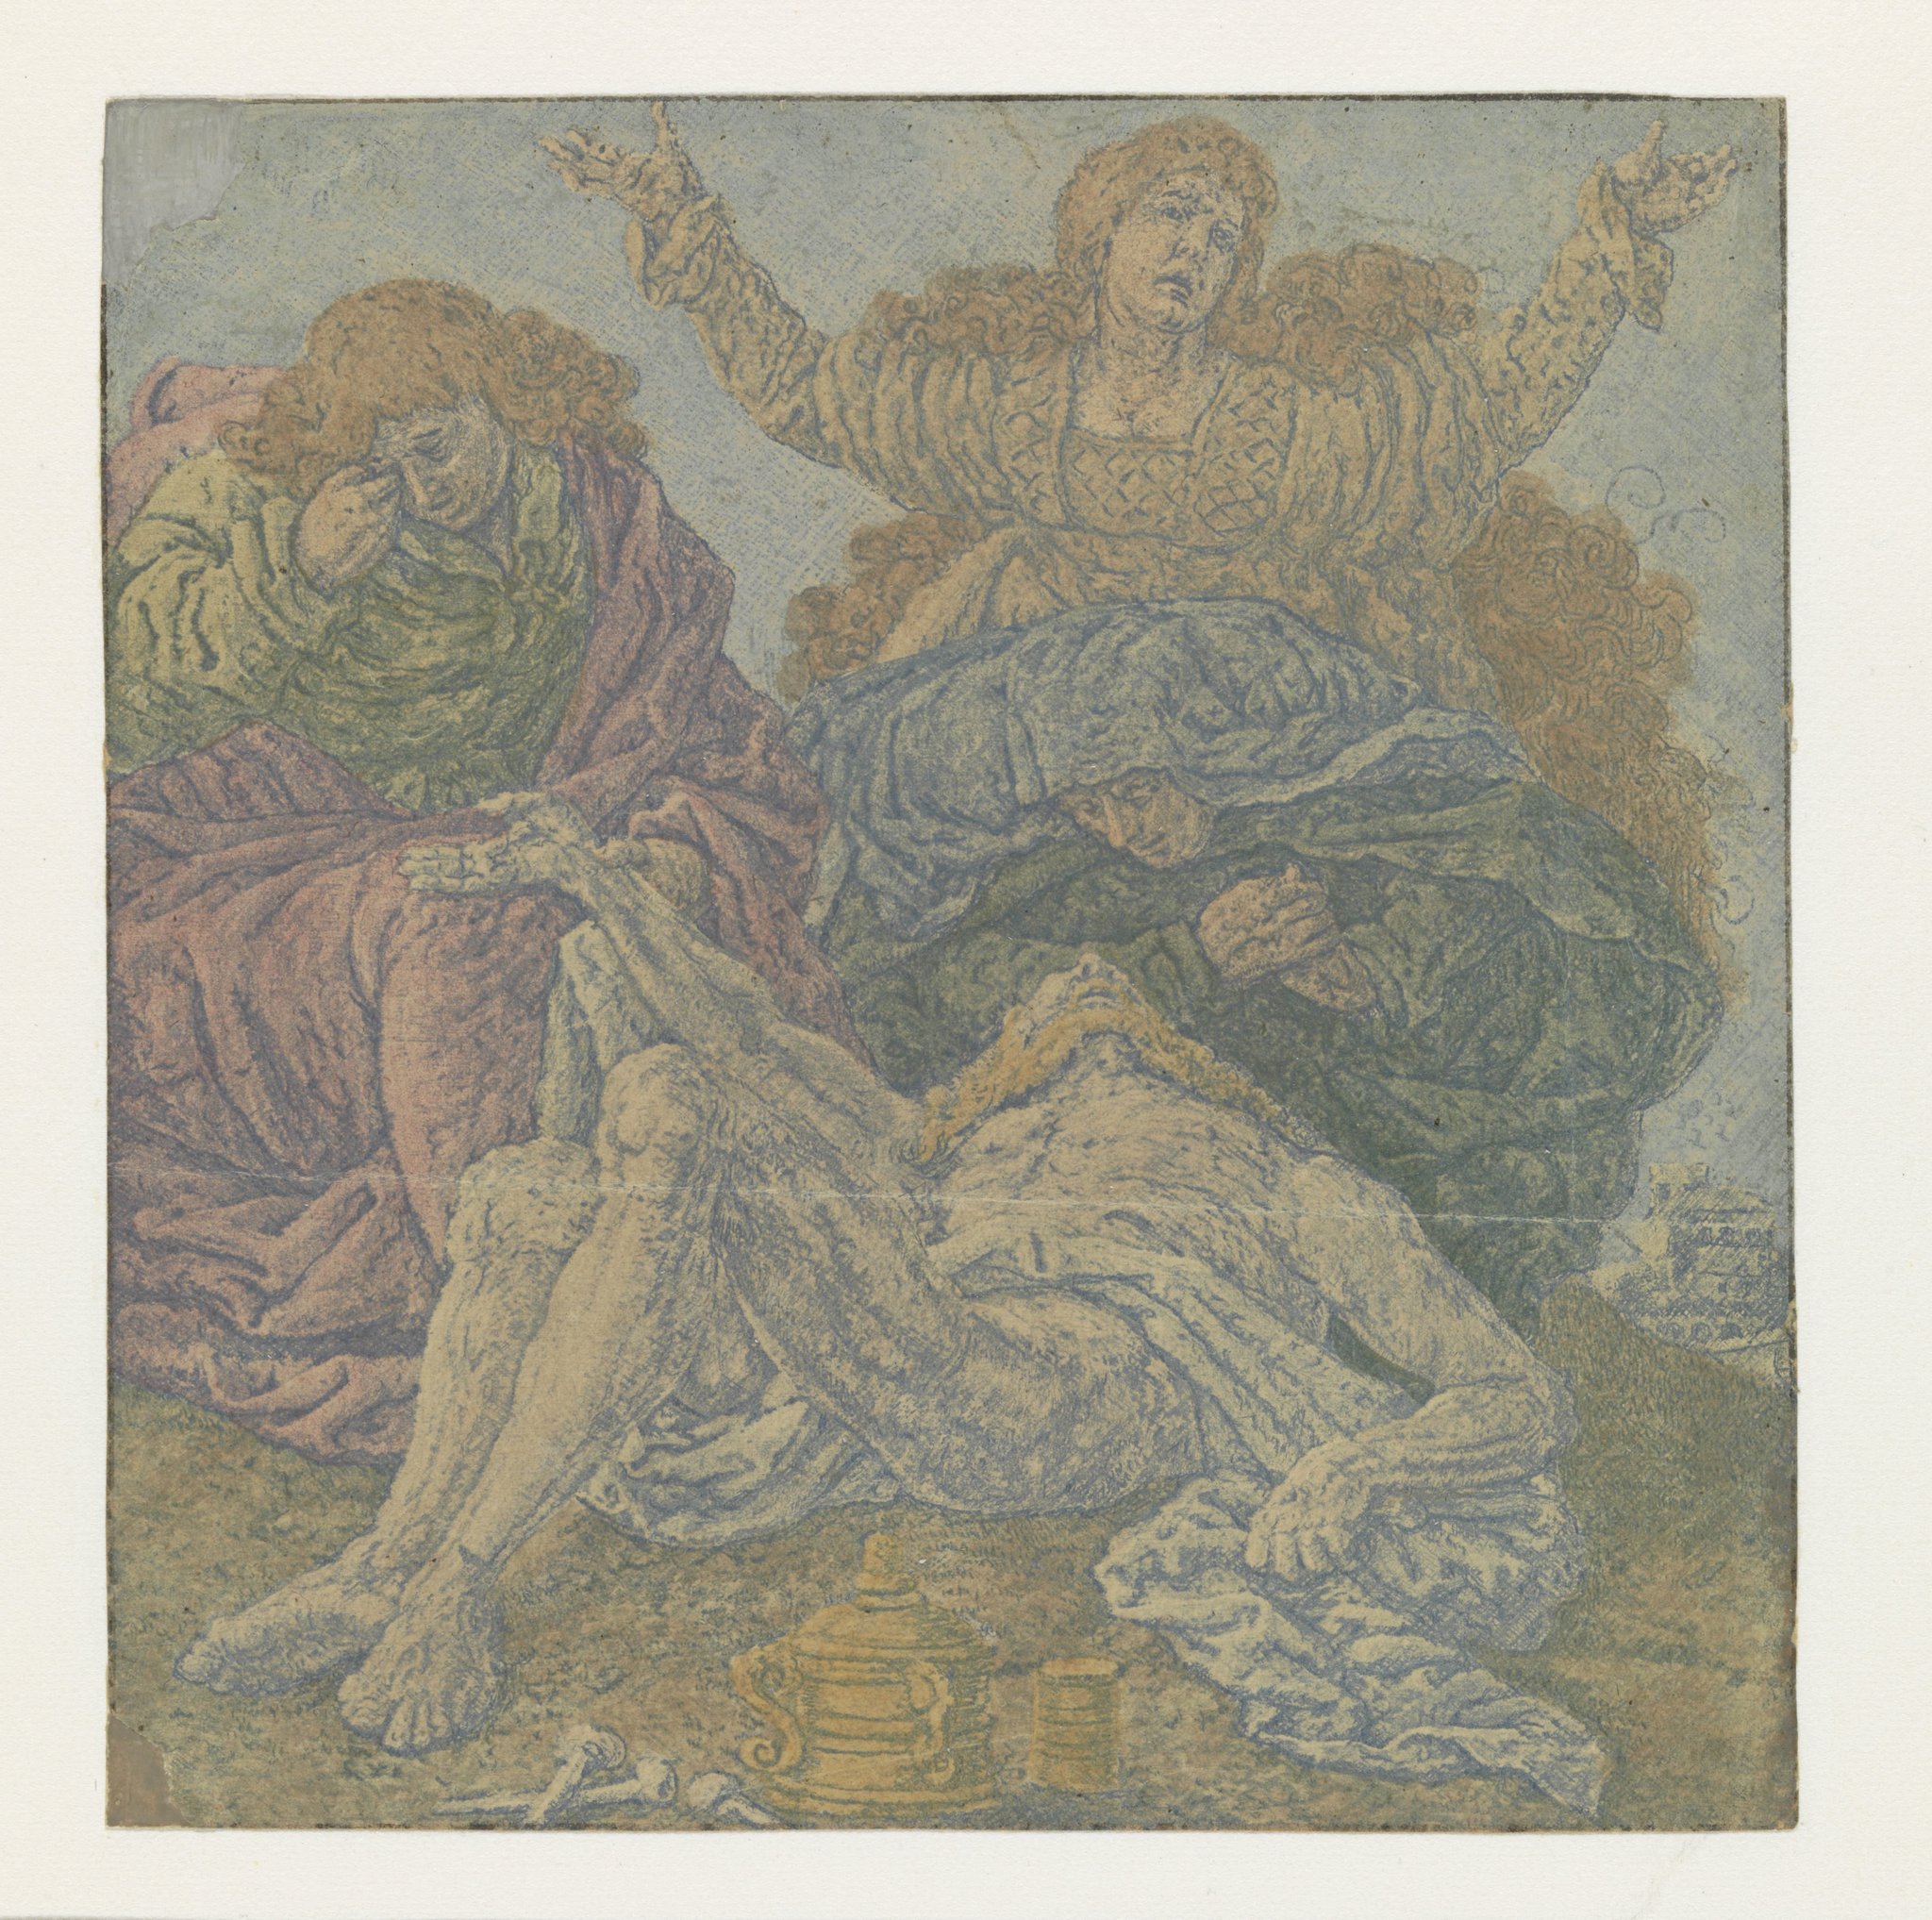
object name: print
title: The Lamentation of Christ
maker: hercules segers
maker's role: draughtsman, painter, print maker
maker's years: 1589-1640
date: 1630-1633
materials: paint, oil, paper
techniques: etching, hand coloring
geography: amsterdam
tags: christ's body lying on the ground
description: Segers overpainted an impression in blue of the same etching on view here (RP-P-OB-797) with body colour and oil paint. He overpainted no other print with so many different colours.